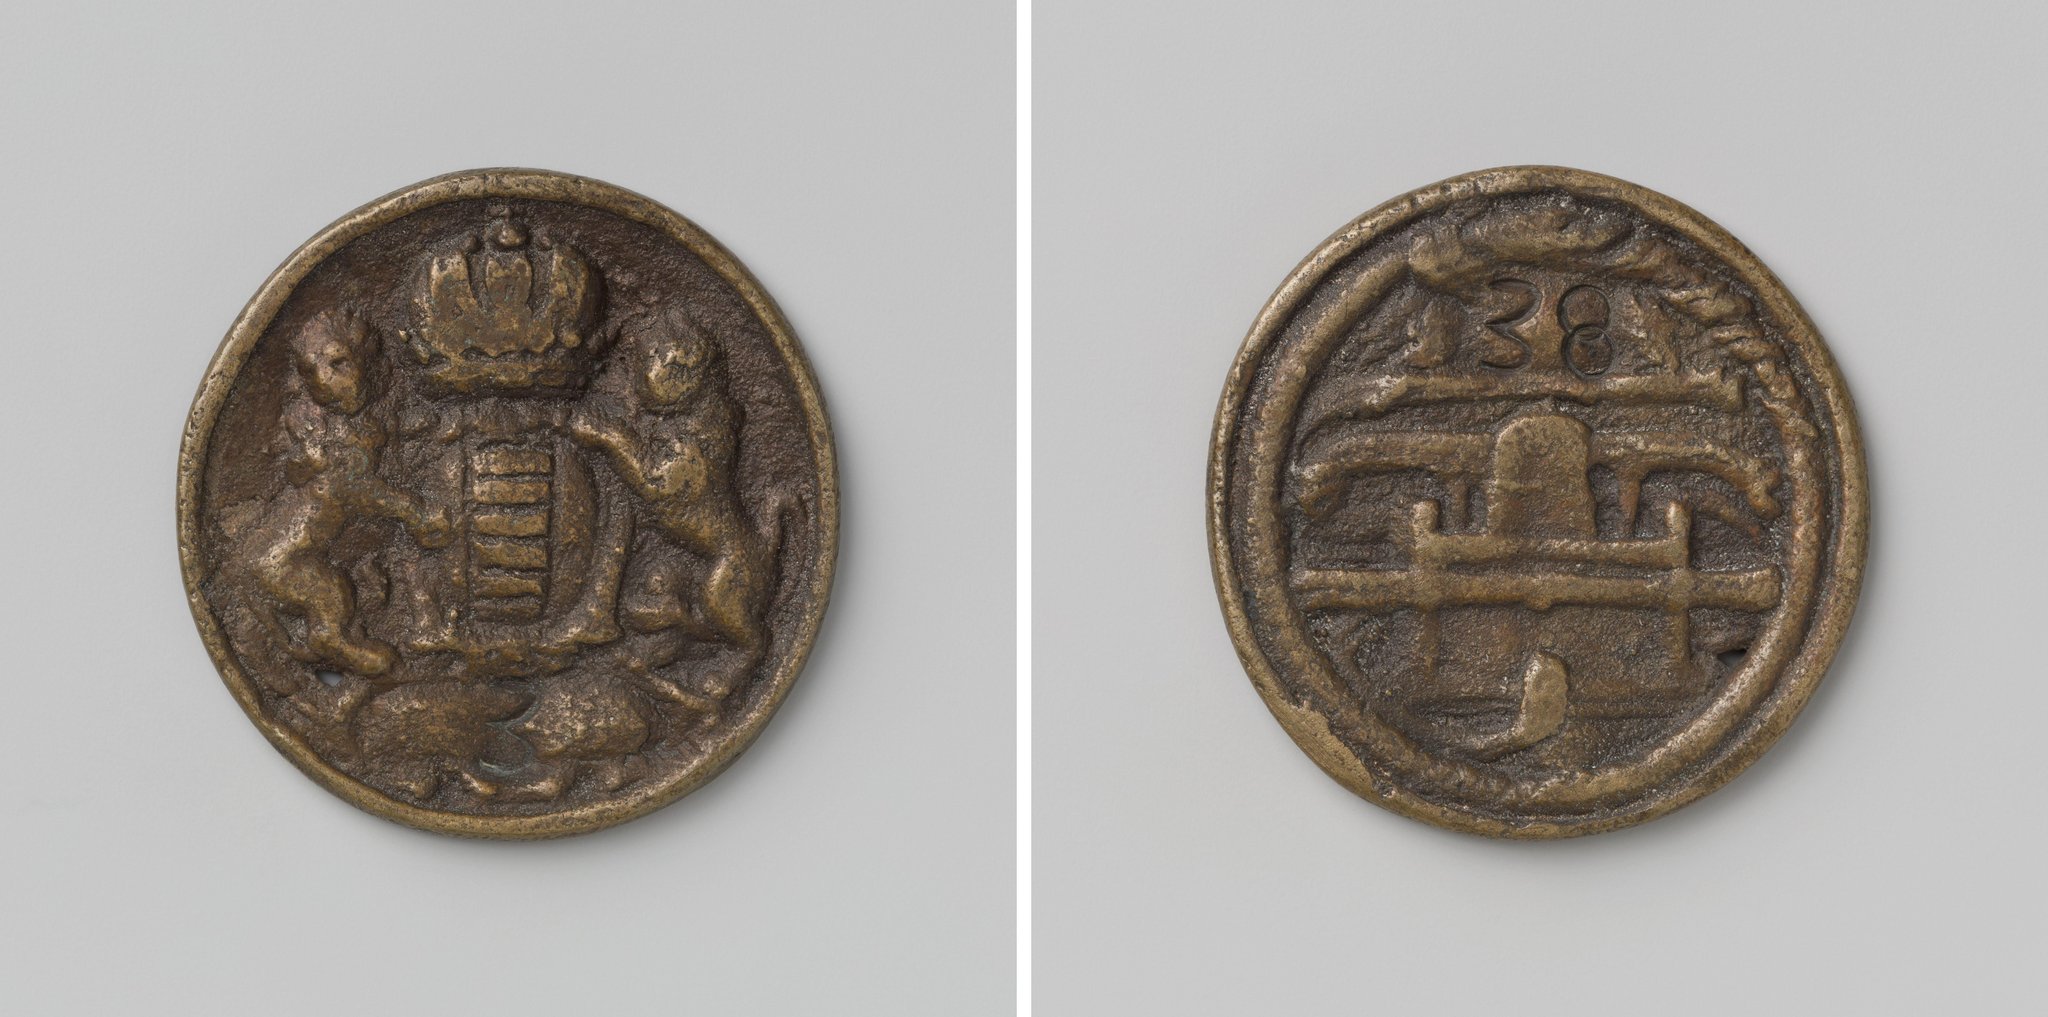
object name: medal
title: Delft, brandspuitpenning van wijk 3 met no. 38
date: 1690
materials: brass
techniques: casting, engraving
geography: delft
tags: delft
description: Messing penning. Voorzijde: gekroond wapenschild, geflankeerd door twee leeuwen boven cartouche met cijfer 3. Keerzijde: brandspuit onder cartouche met cijfer 38 binnen slangerond